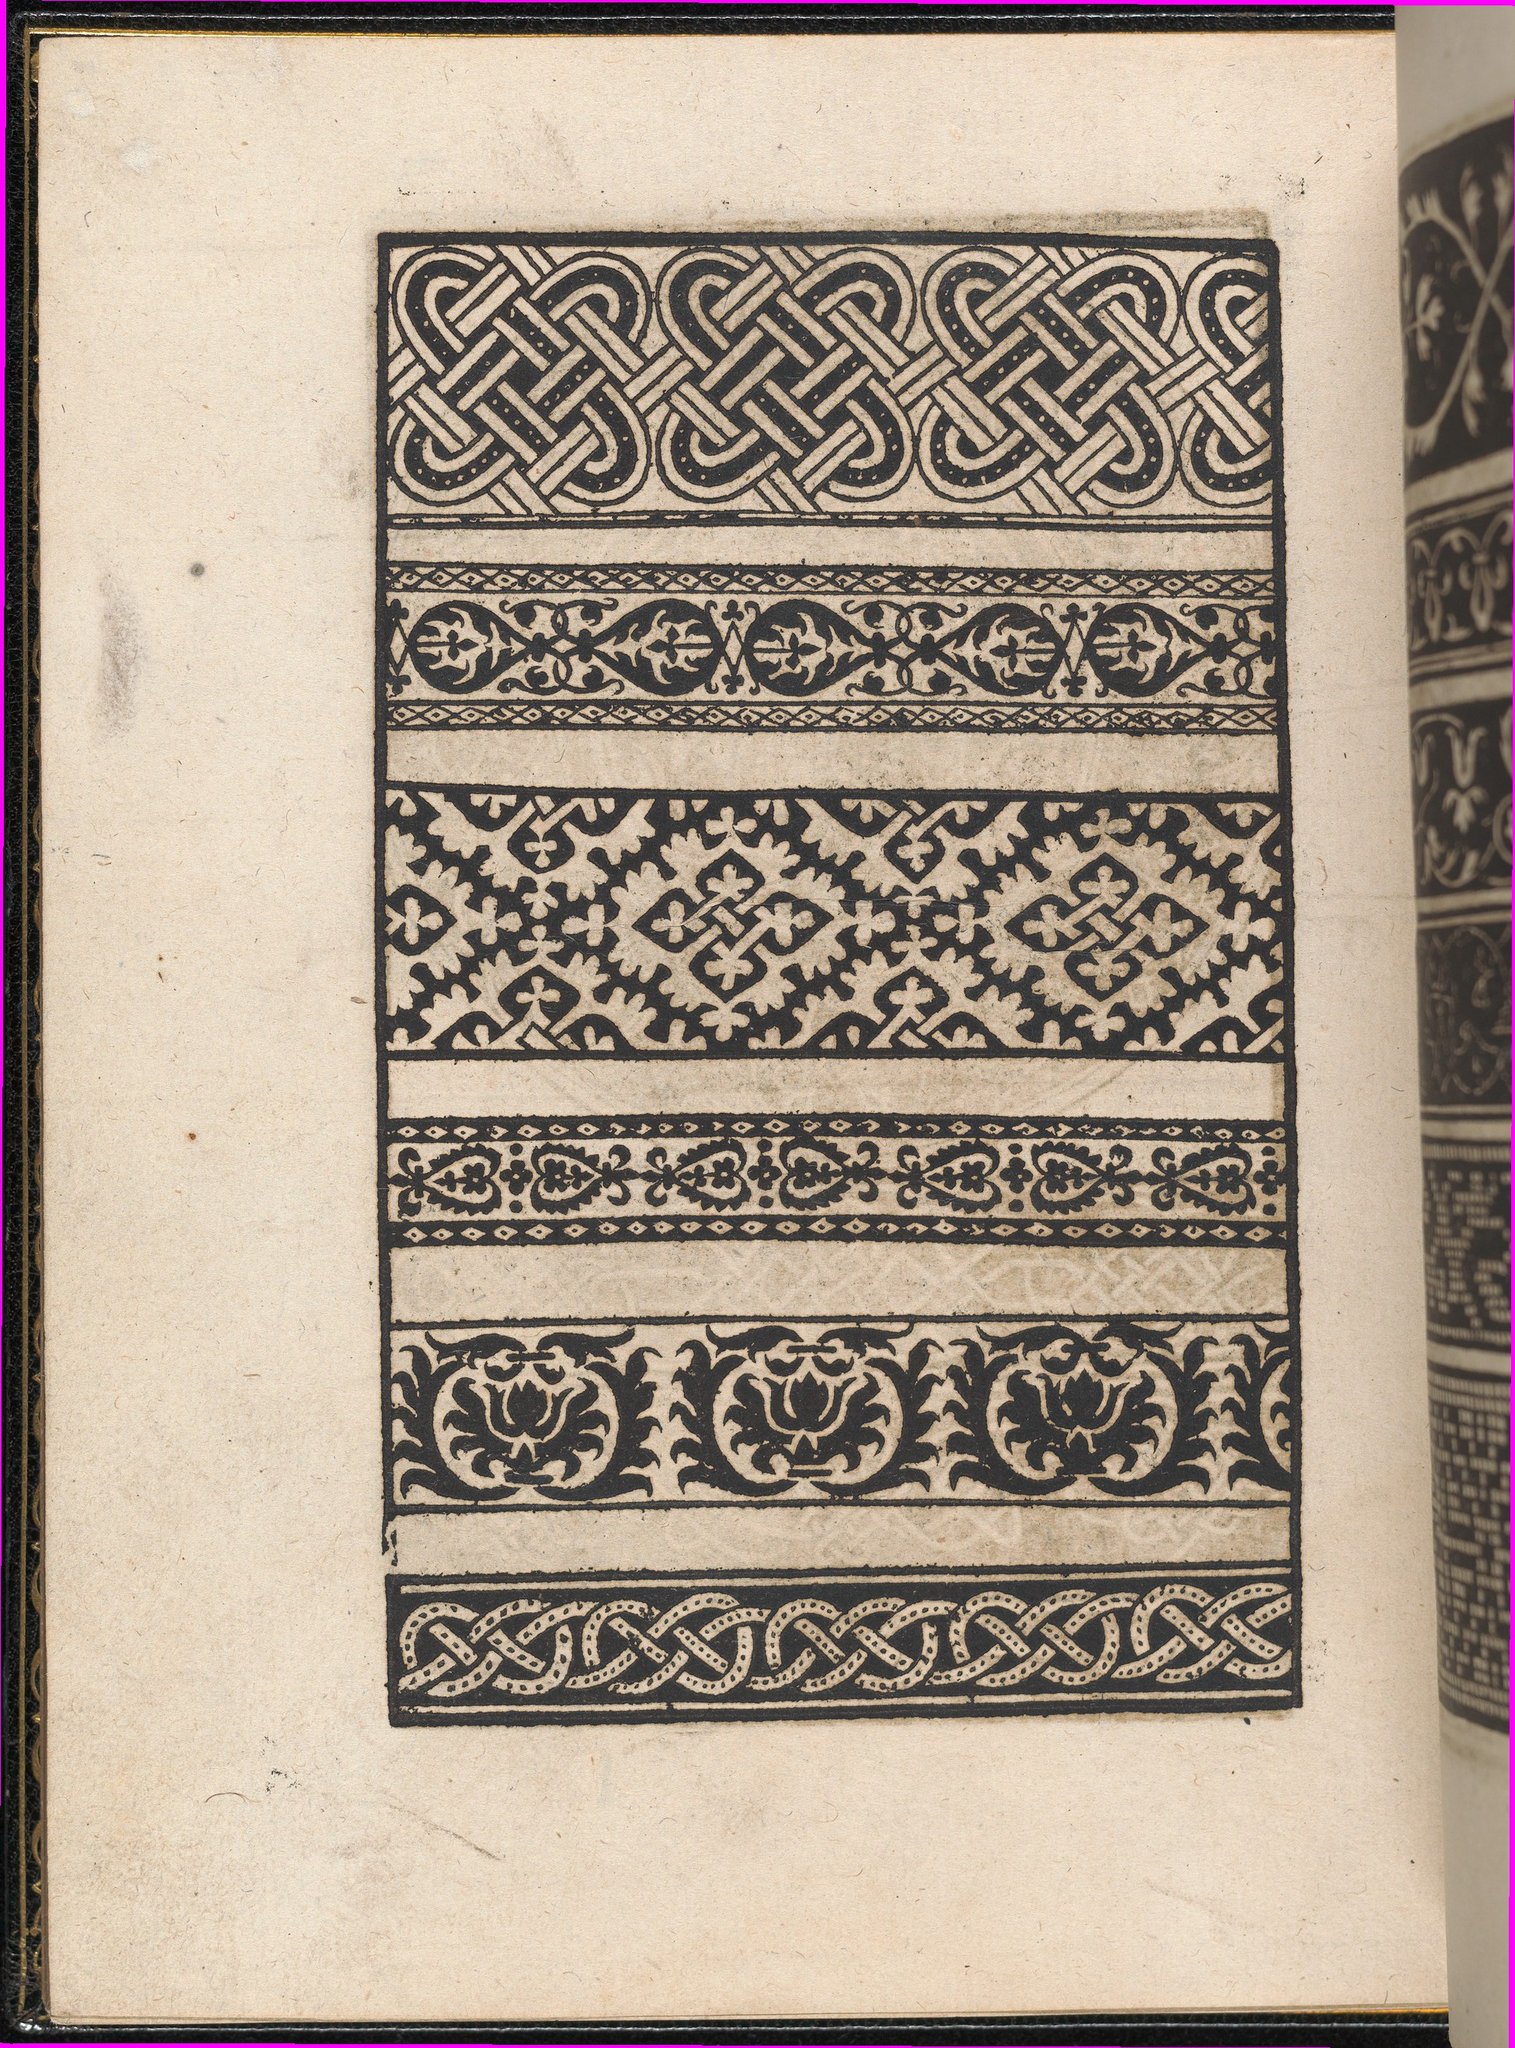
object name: book print ornament architecture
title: Page from Ein new kunstlich Modelbuch...(Page 48v)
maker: peter quentel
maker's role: publisher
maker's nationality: german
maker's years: 1500-1550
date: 1544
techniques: woodcut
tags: ornament